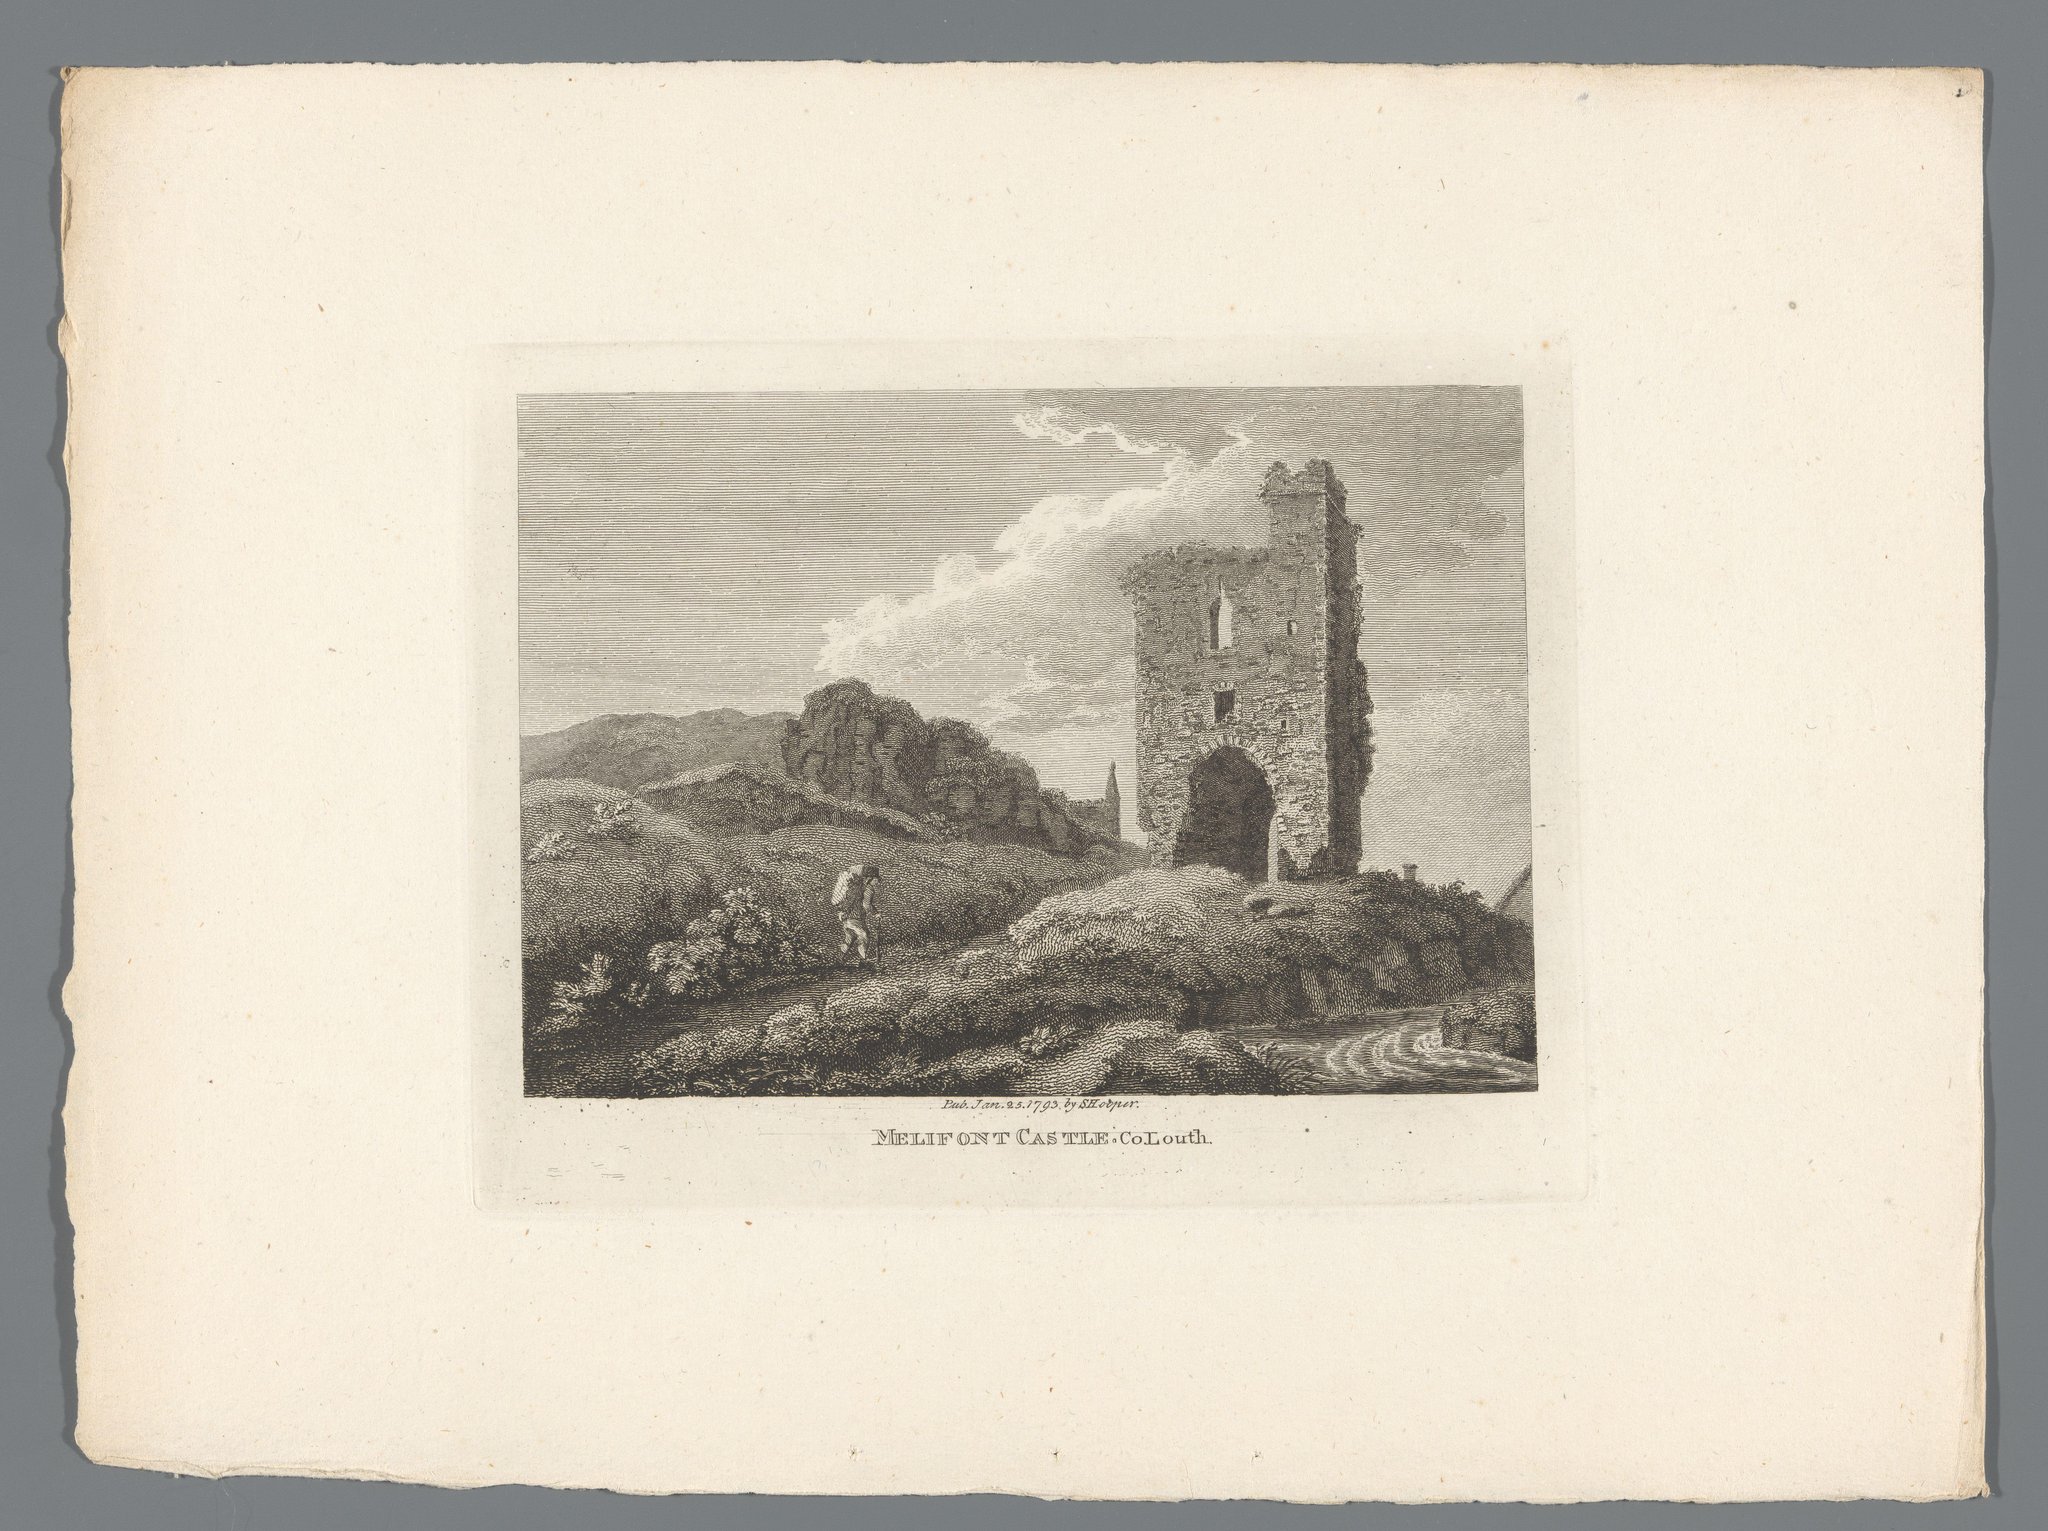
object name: print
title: Melifont Castle. Co.Louth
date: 1793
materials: paper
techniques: etching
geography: london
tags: landscape with ruins, landscape with tower or castle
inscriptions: date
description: Prent lijkt te horen bij RP-P-2018-3722, maar is niet in de uitgave verschenen.